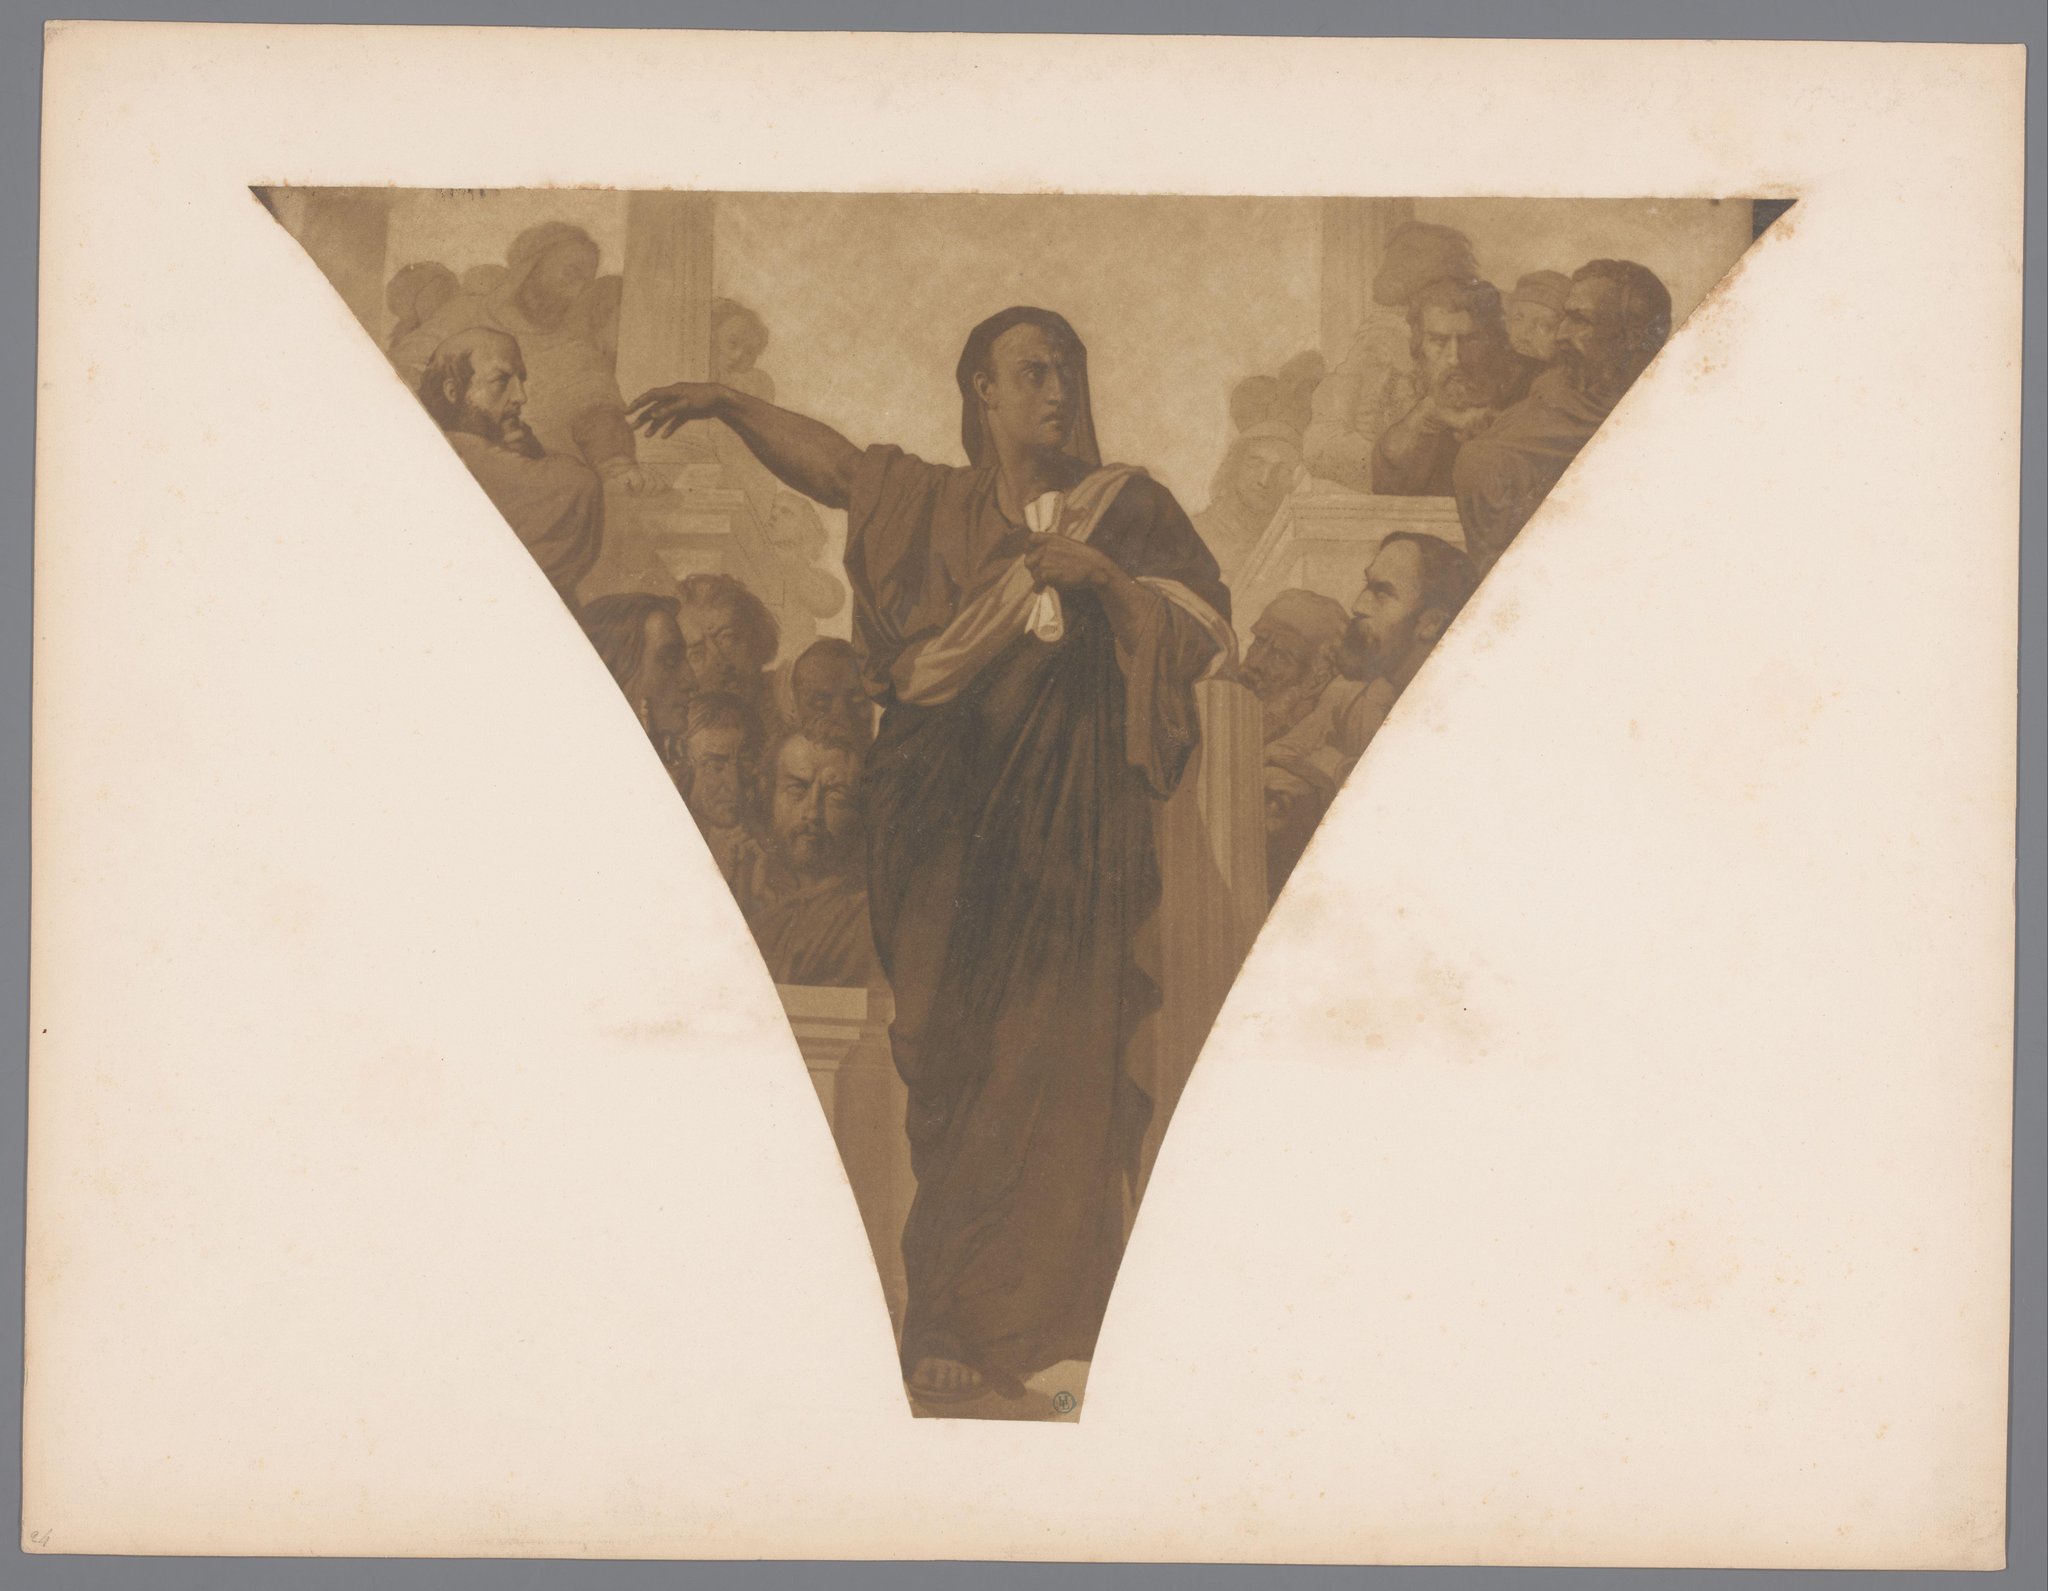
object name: photograph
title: Fotografische reproductie van decoratie aan plafond, Hotel de Ville, Parijs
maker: gustave le gray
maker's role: fotograaf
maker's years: 1820-1884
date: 1852-1853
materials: cardboard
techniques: salted paper print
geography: paris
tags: paris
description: Maakt onderdeel uit van een serie van 18 bladen met foto's van de cartons voor de plafondschilderingen door Henri Lehmann voor de Galerie des Fêtes in het Hotel de Ville, Parijs.